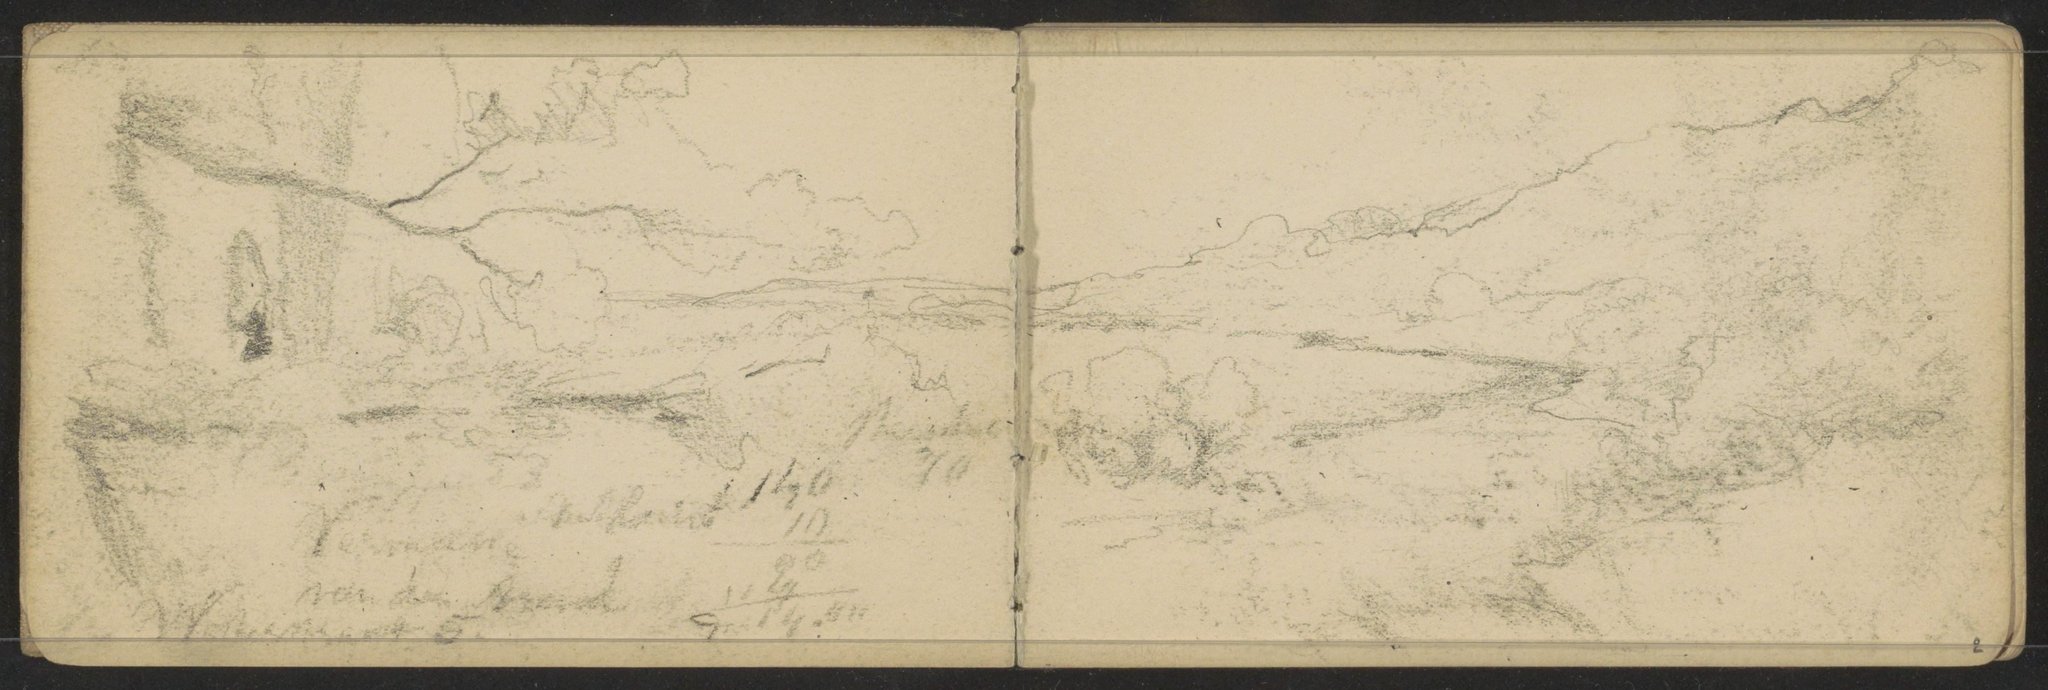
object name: sketchbook leaf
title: Heuvellandschap en bomen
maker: willem cornelis rip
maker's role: draughtsman, painter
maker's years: 1856-1922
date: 1892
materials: paper, pencil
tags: low hill country, trees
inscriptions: annotation: ‘Ver[...]/ 140 70/ [...]/ We[...]’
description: Blad 1 verso en 2 recto uit een schetsboek met 25 bladen.